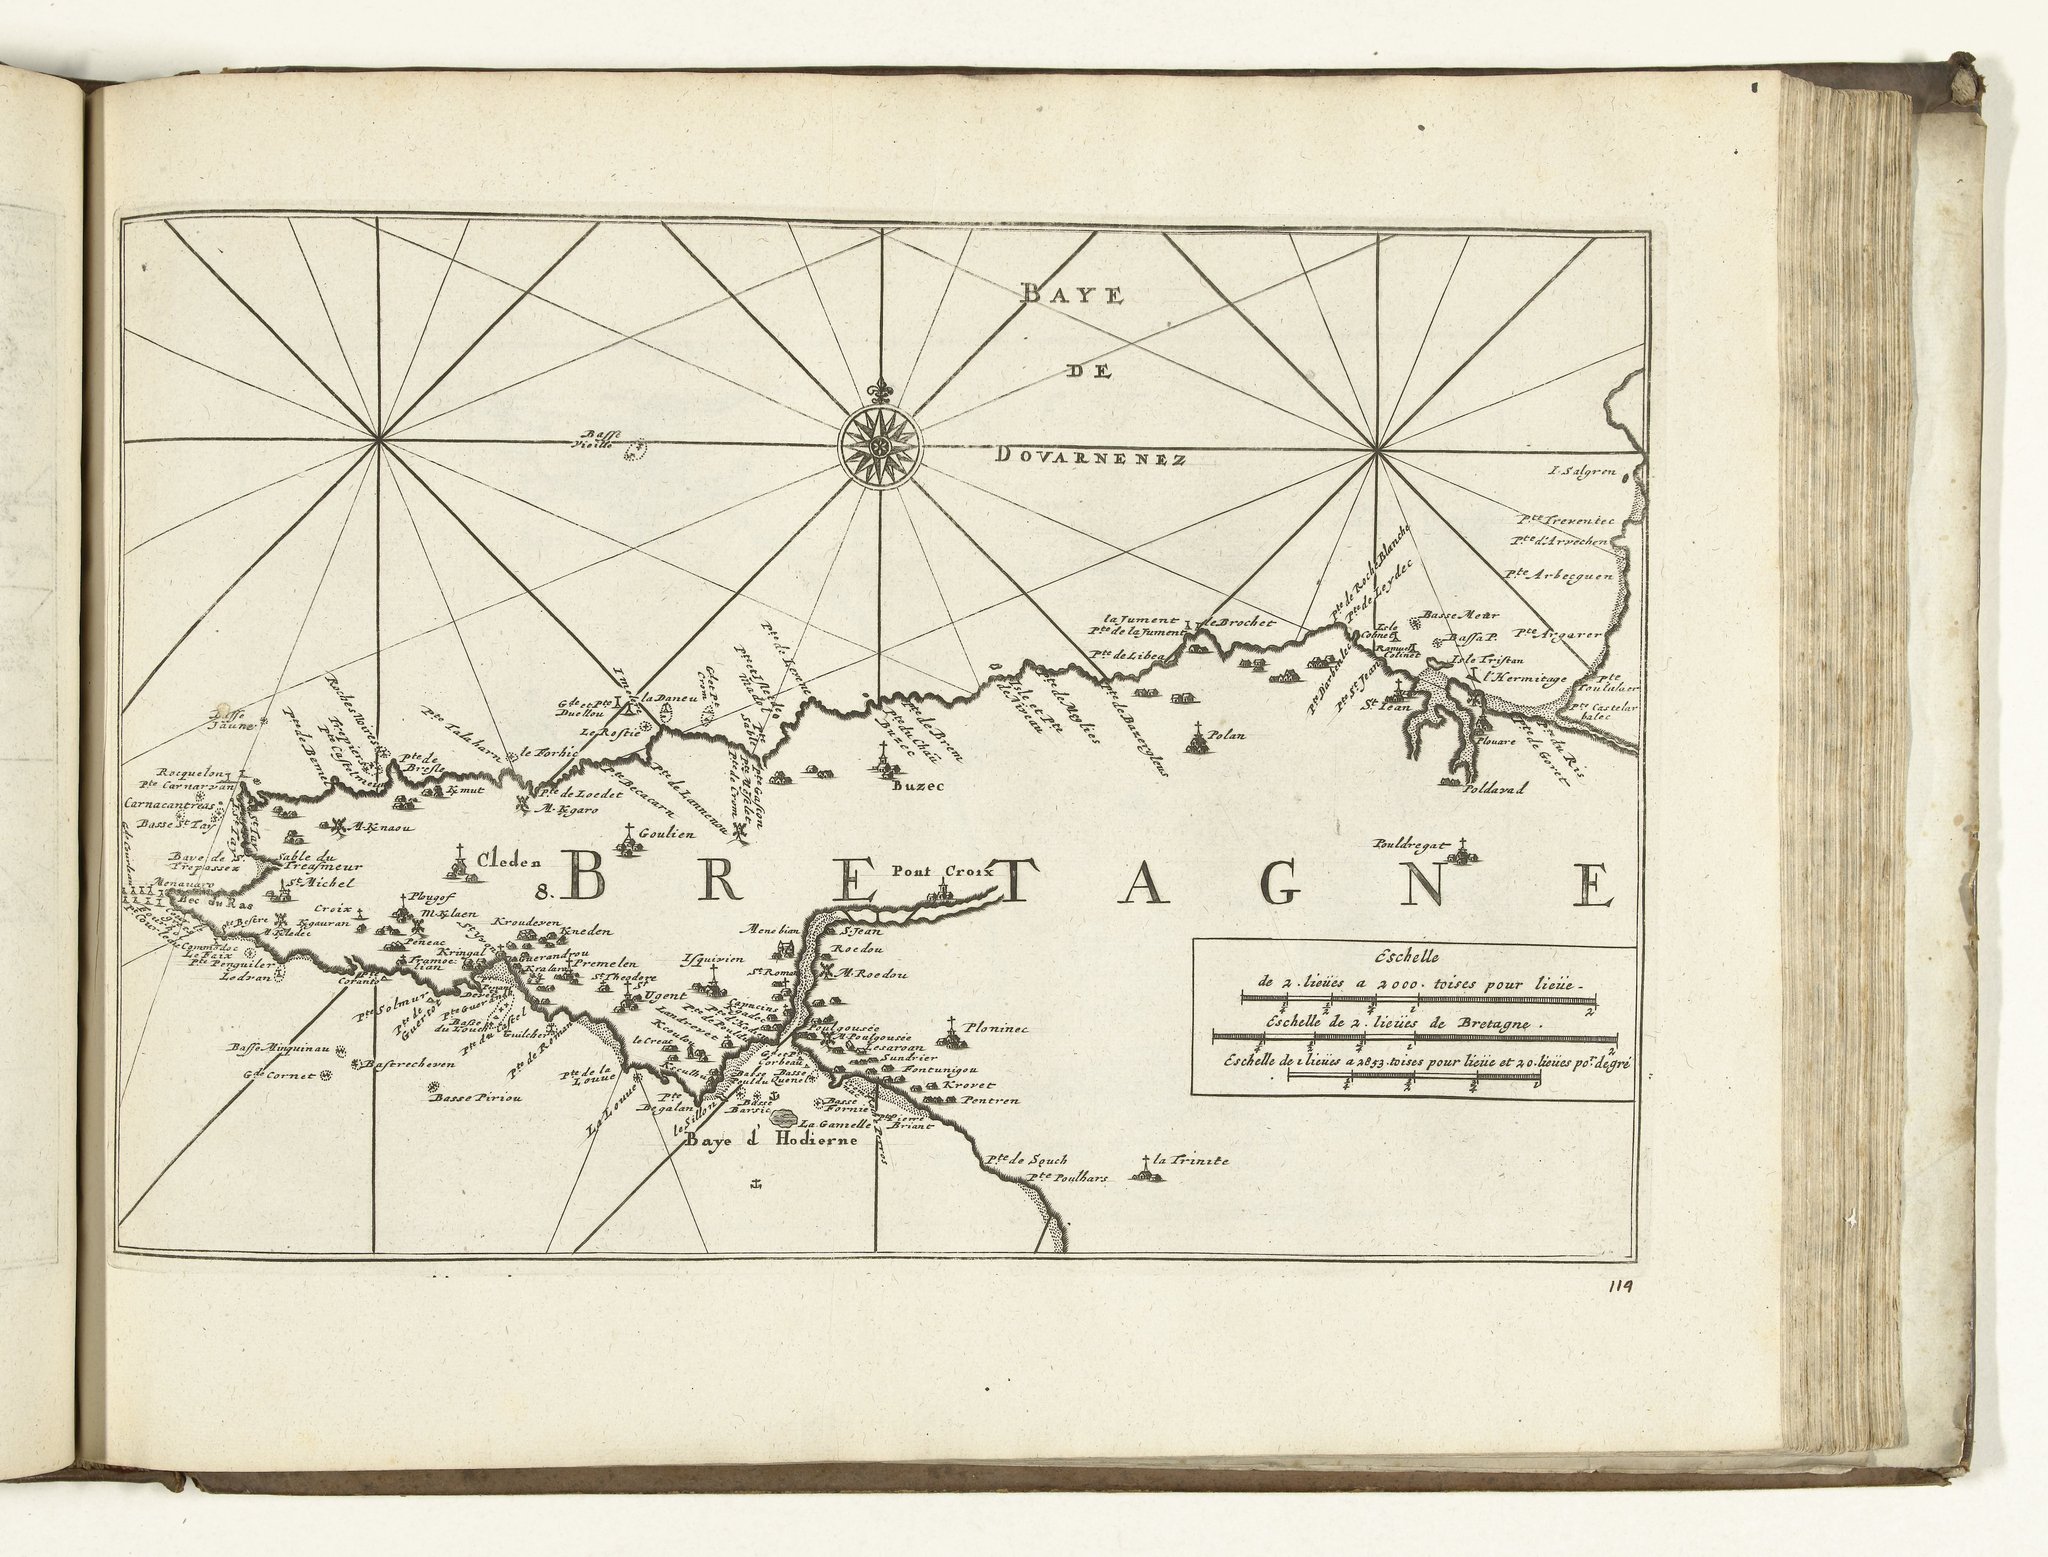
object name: map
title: Les Forces de l'Europe, Asie, Afrique et Amerique (...) Comme aussi les Cartes des Côtes de France et d'Espagne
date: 1726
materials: paper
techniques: engraving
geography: leiden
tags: maps of separate countries or regions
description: Kaart van de westkust van Bretagne. Plaat nr. 114 in deel V van het prentwerk: Les Forces de l'Europe, Asie, Afrique et Amerique ... Comme aussi les Cartes des Côtes de France et d'Espagne uit 1726, dit eerste deel met 238 met de hand genummerde platen van vermaarde sterke steden en vestingen in het kader van de Spaanse Successieoorlog 1701-1713. Voor het merendeel zijn deze platen gekopieerd naar de anonieme Franse platen van vermaarde sterke steden en vestingen: in Les forces de l'Europe en in: Le theatre de la guerre, dans les Pays-Bas, beide oorspronkelijk uitgegeven door Nicolas de Fer te Parijs (1693-1697) in het kader van de Negenjarige Oorlog. Opschriften in het Frans.